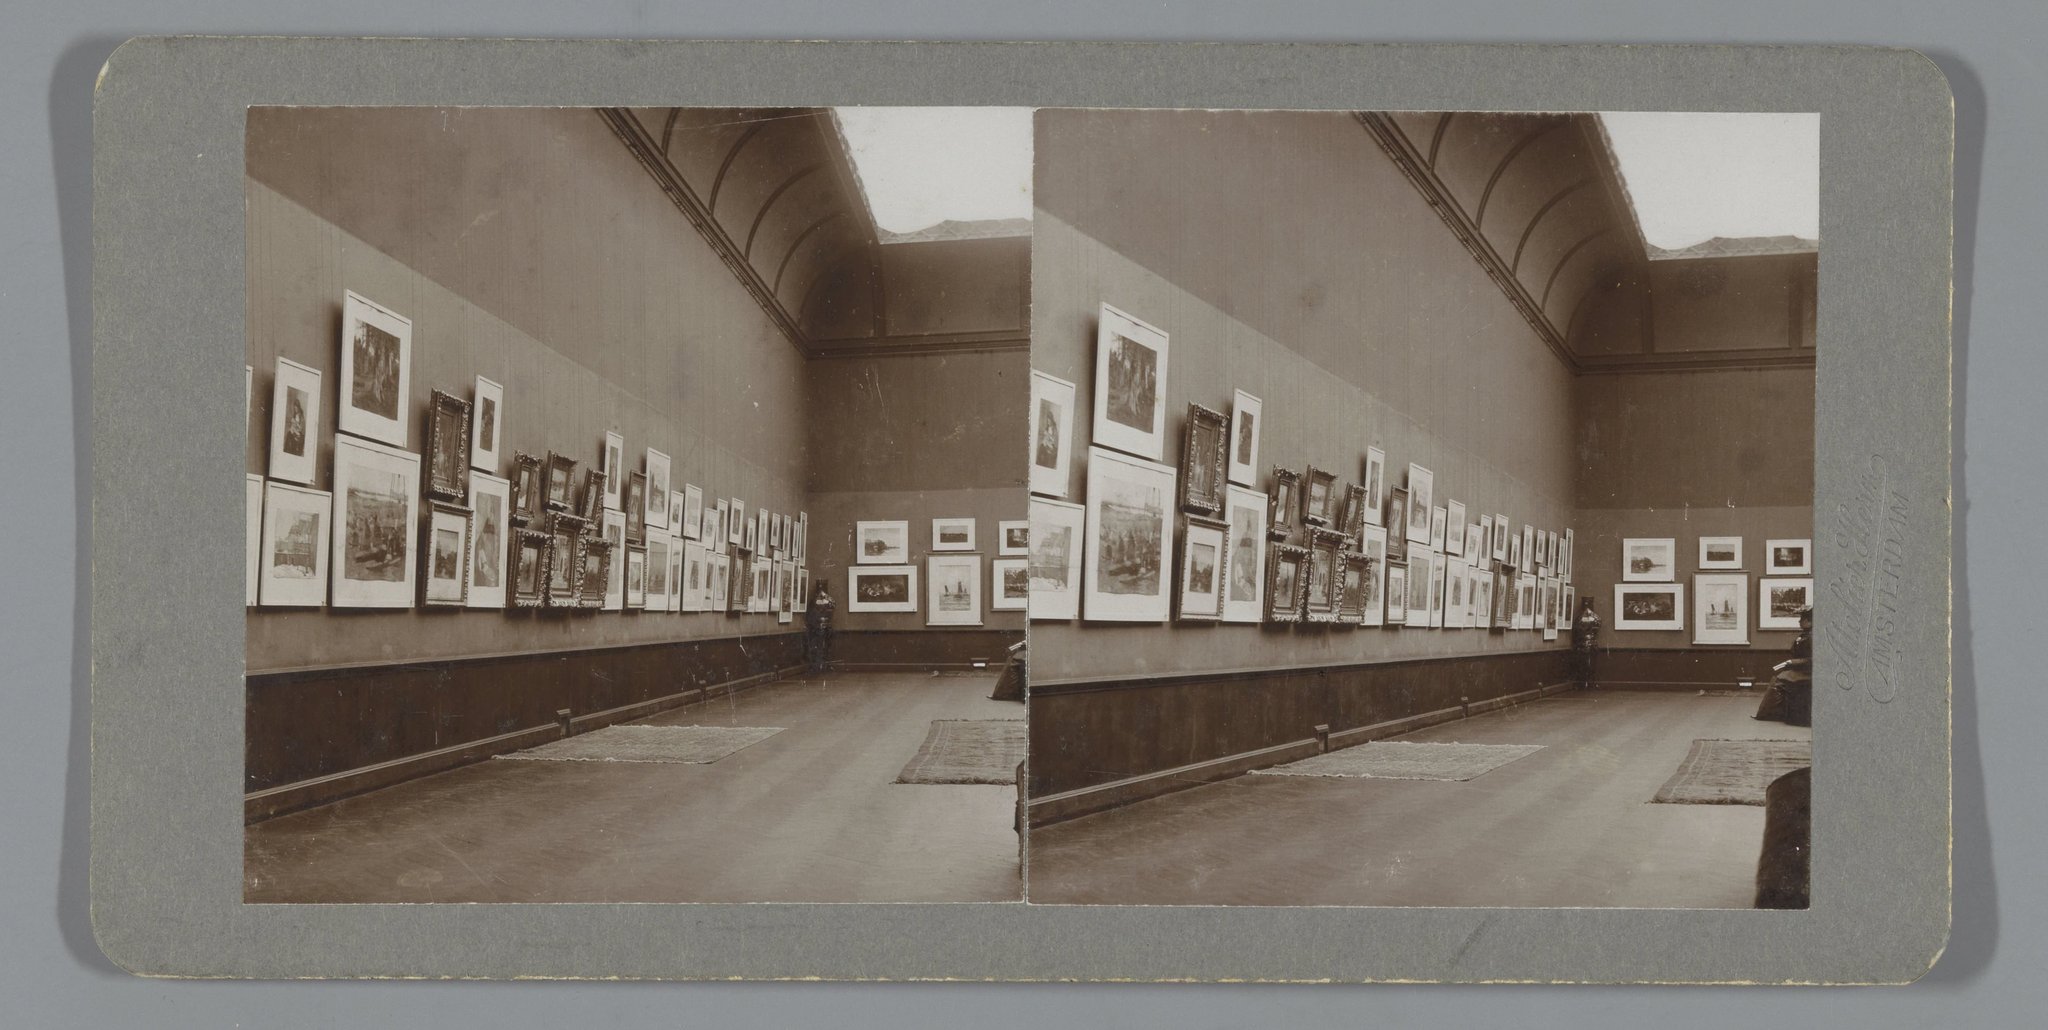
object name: stereograph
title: Gezicht in een zaal van het Stedelijk Museum, Amsterdam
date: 1902-1920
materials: paper, cardboard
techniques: gelatin silver print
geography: amsterdam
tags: collection, exhibition, show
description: Tijdens een tentoonstelling van de Vereeniging tot het Vormen van eene openbare verzameling van Hedendaagsche Kunst (VVHK, ook wel de 'vereeniging met de lange naam' genoemd).